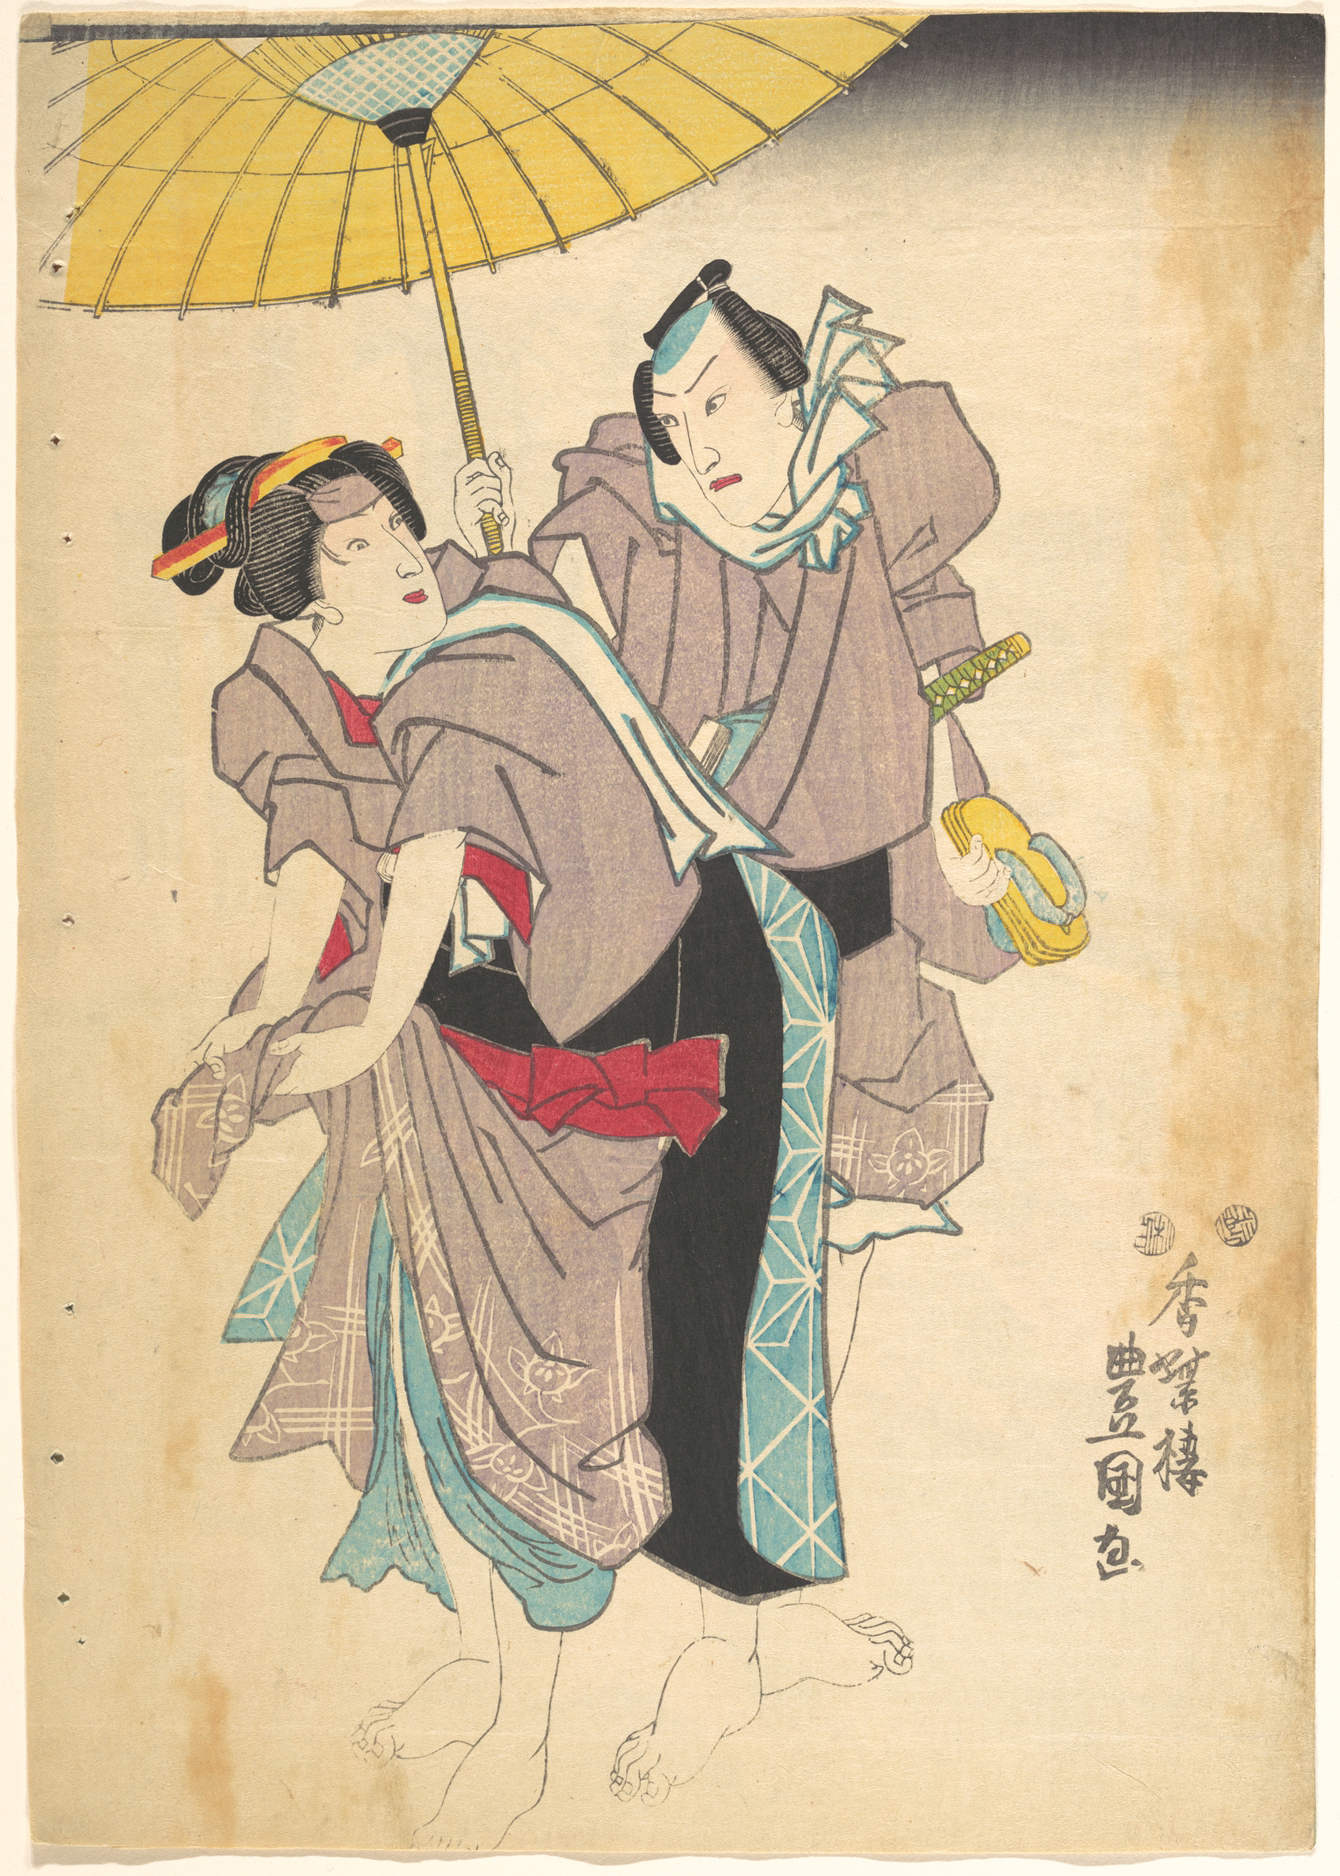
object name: print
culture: japanese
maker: utagawa kunisada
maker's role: artist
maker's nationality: japanese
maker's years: 1786-1864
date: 1801-1900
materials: ink, paper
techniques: woodblock print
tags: men,women,parasols